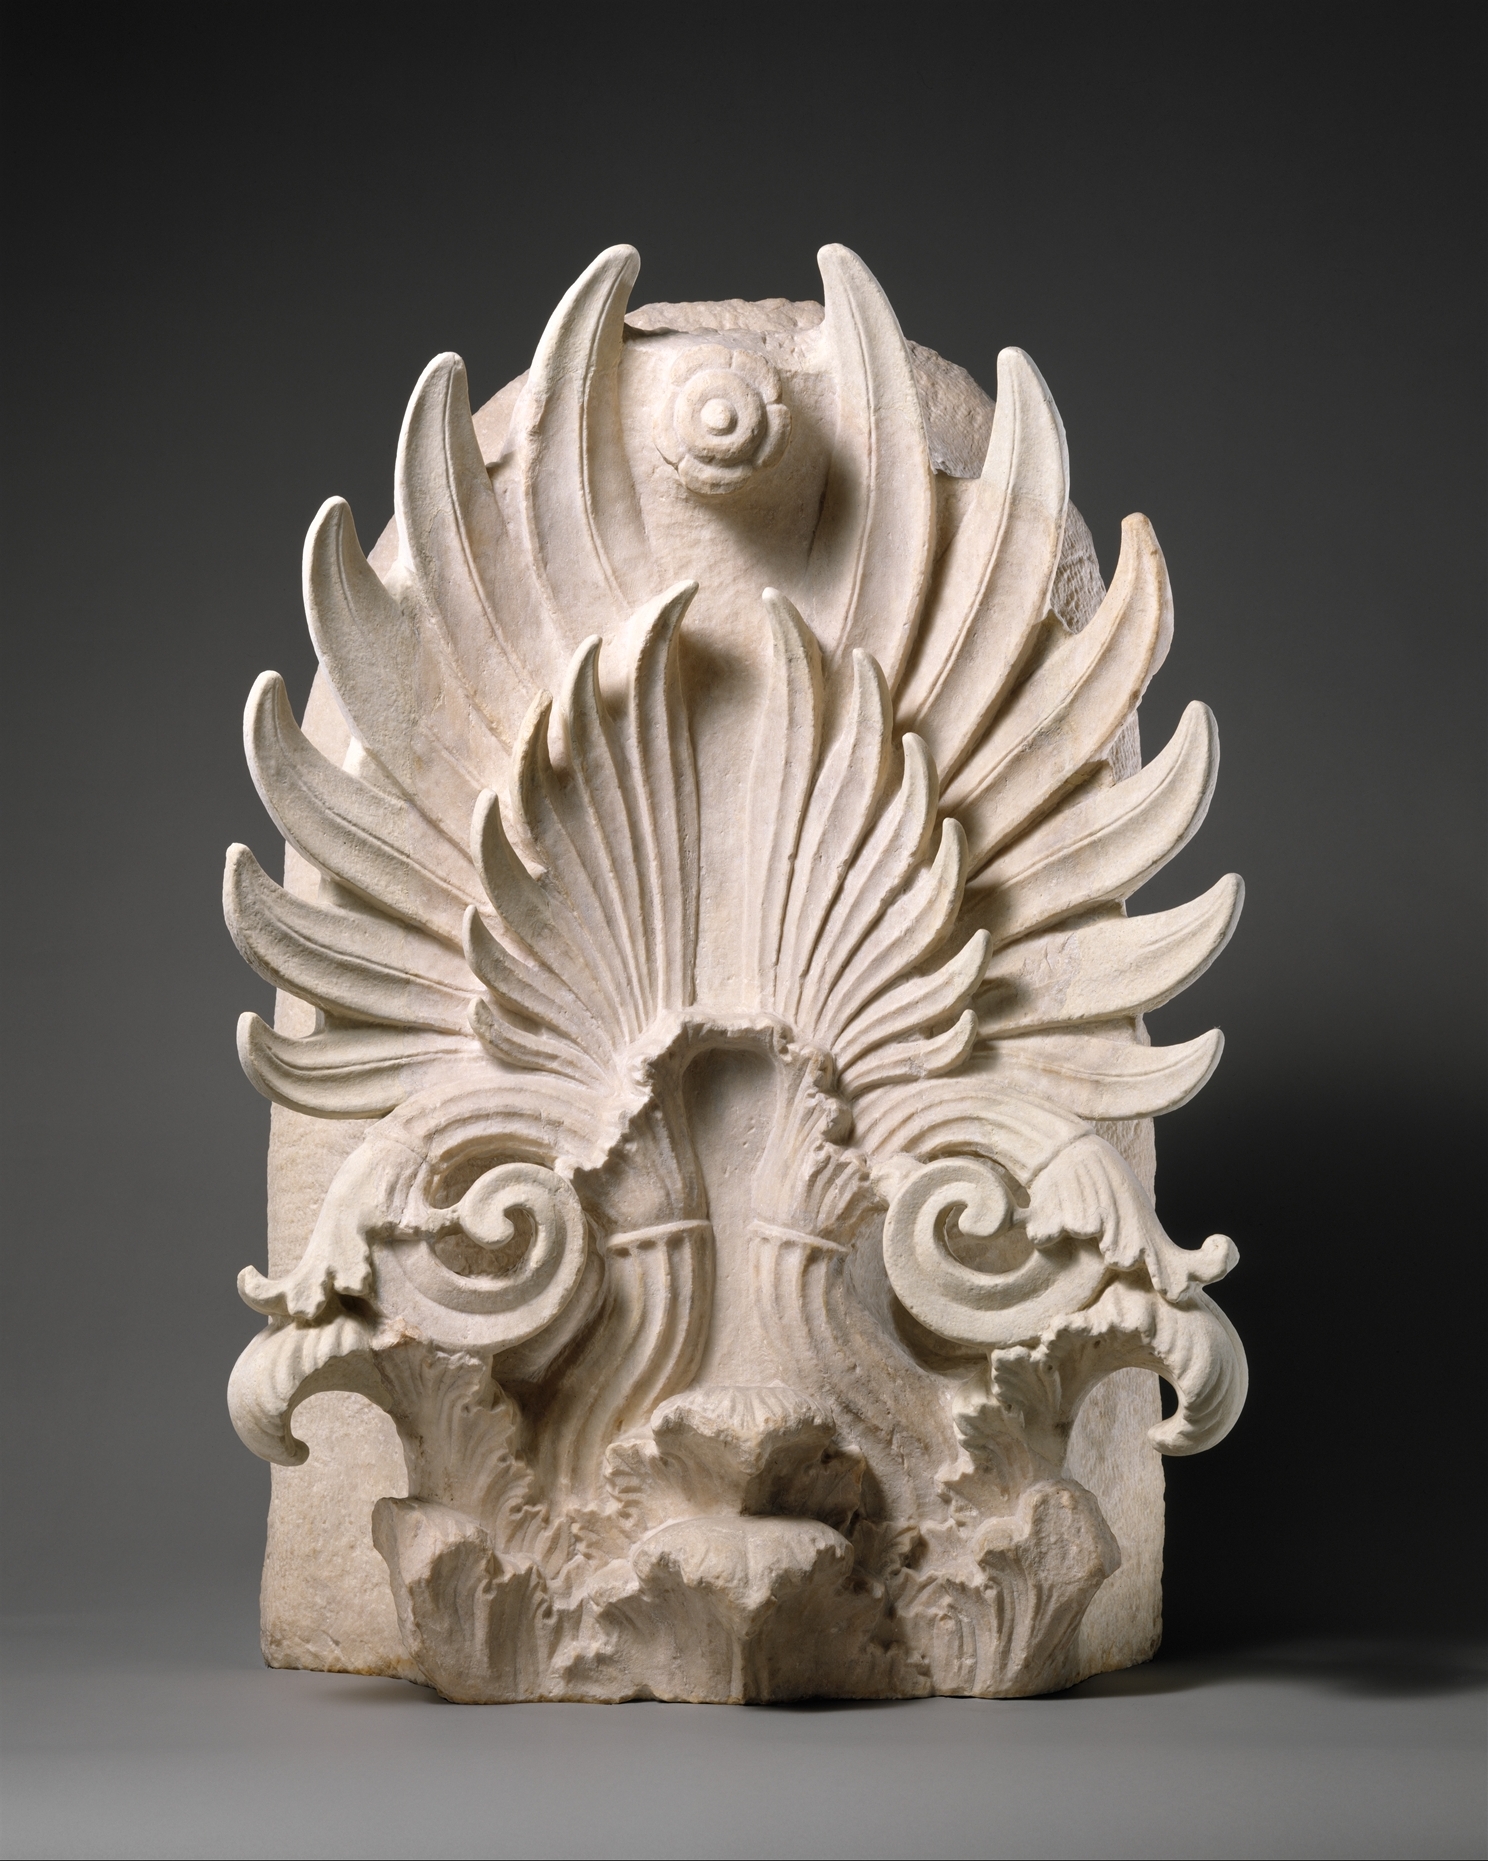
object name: akroterion of a gravestone with palmette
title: Marble akroterion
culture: greek, attic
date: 350-325 BCE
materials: marble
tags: palmettes